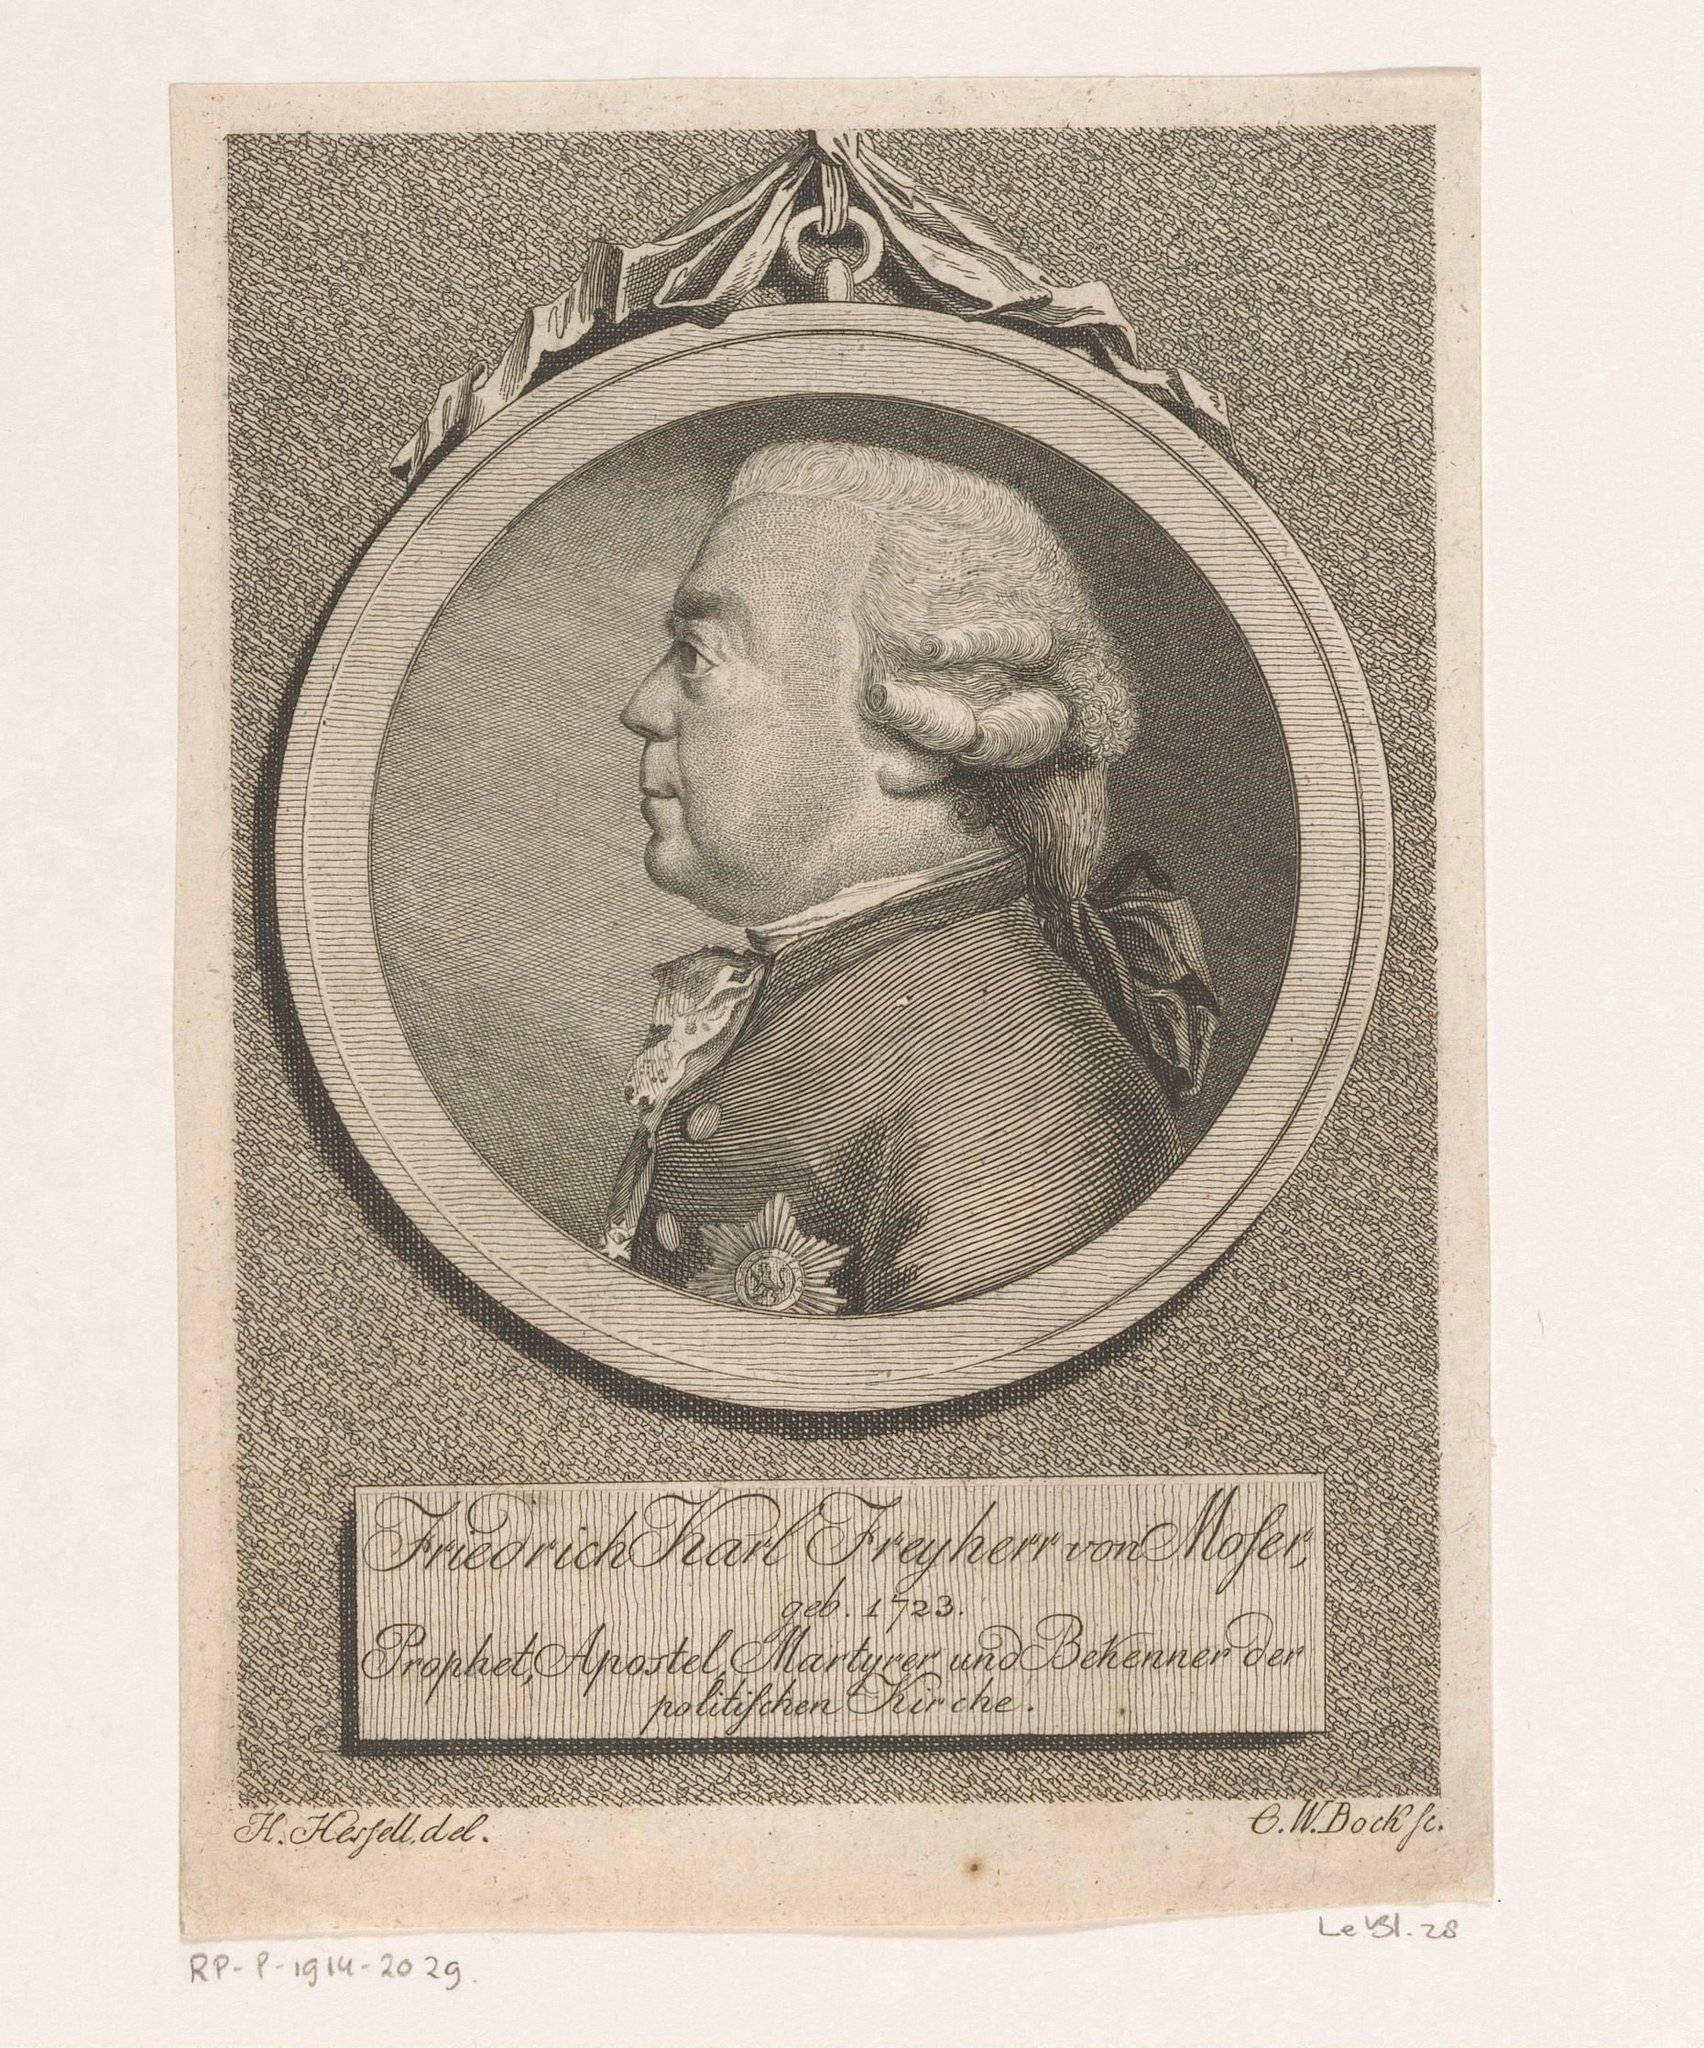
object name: print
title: Portret van Friedrich Carl, Freiherr von Moser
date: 1765-1836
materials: paper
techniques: engraving, etching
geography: nuremberg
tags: knighthood order, historical persons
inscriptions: collector's mark: Lugt 2228